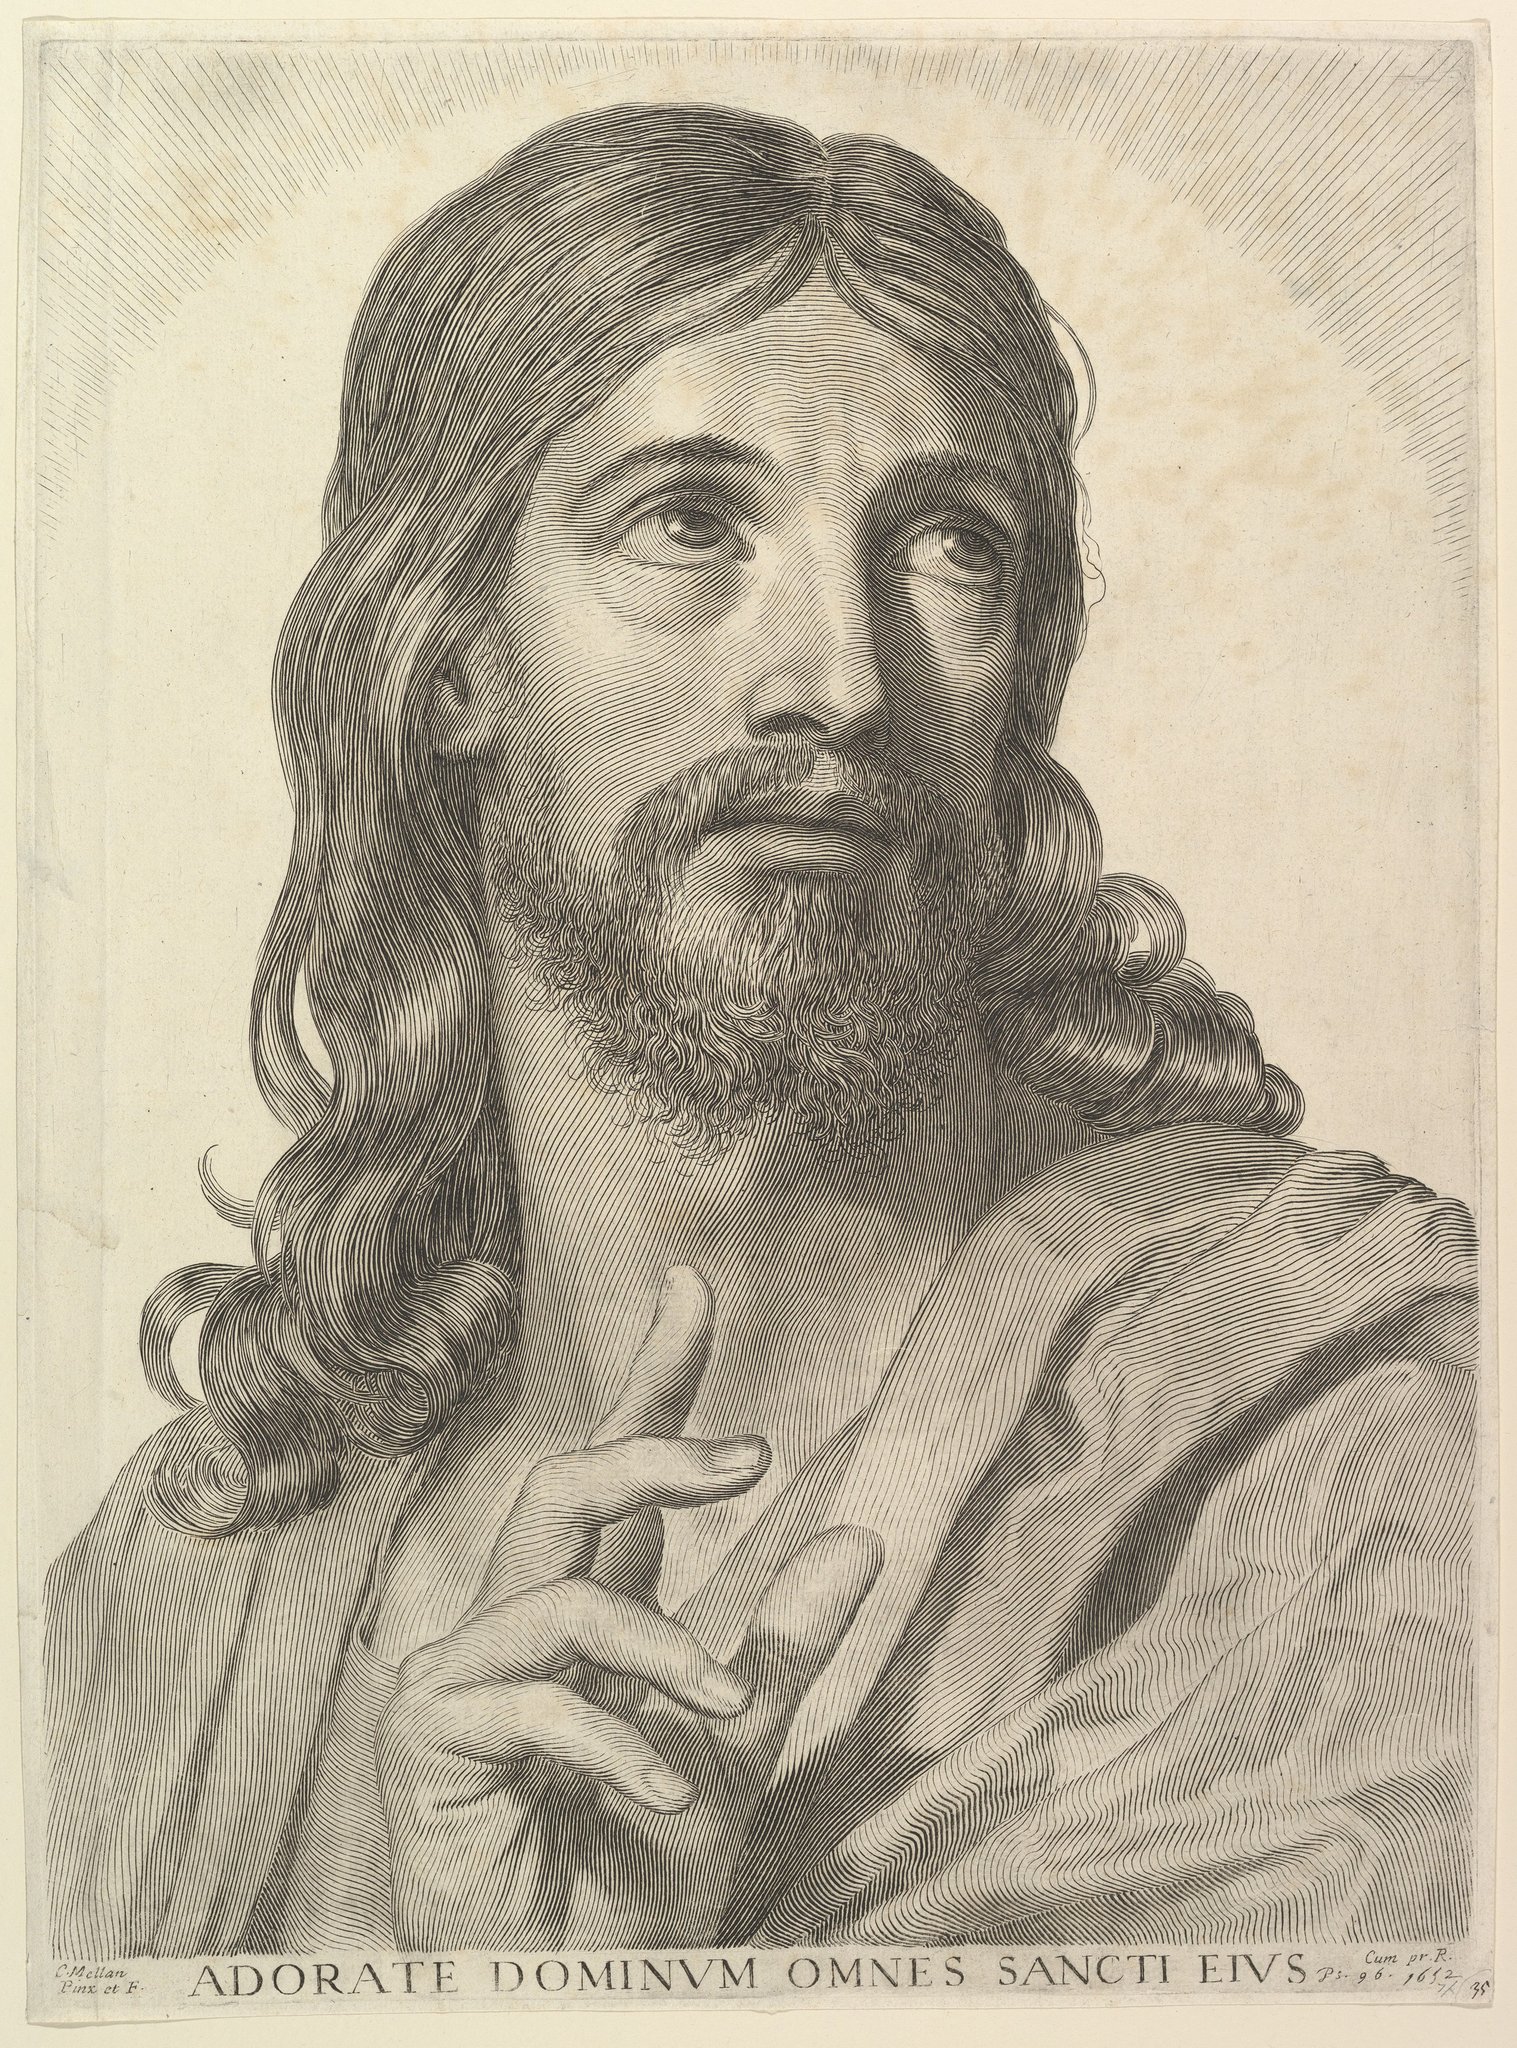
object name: print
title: Bust of the Adult Christ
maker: claude mellan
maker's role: artist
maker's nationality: french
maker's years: 1598-1688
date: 1652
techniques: engraving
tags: portraits,christ